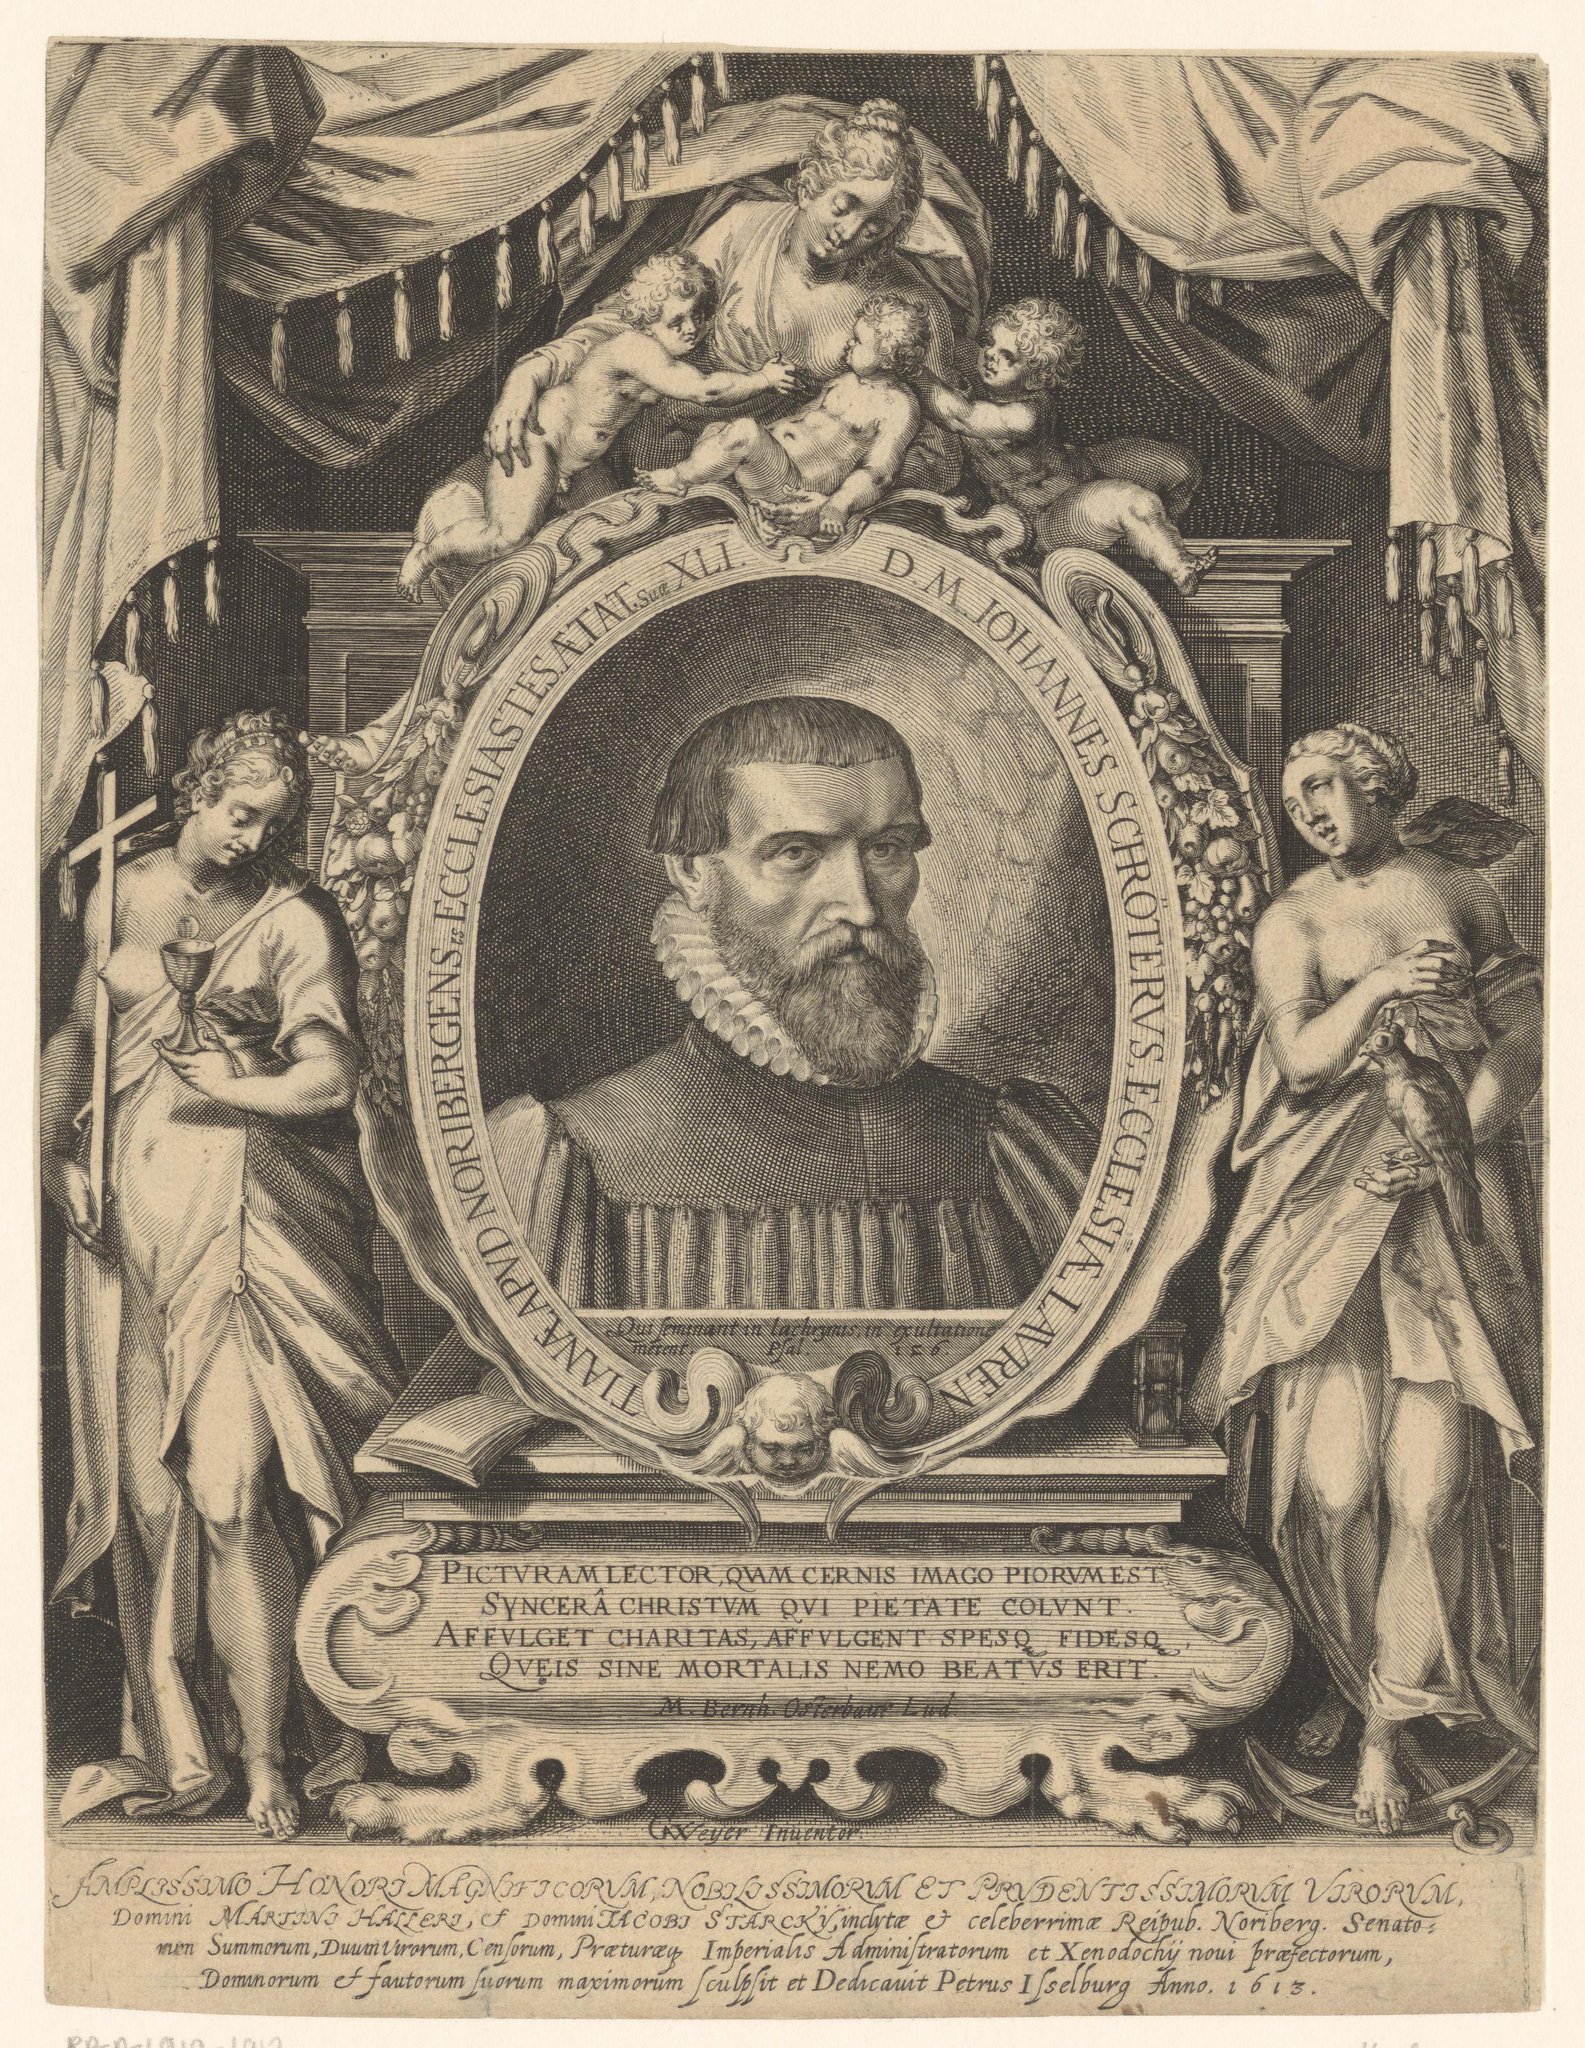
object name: print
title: Portret van Johann Schröder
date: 1613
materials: paper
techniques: engraving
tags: theologian, historical persons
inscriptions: collector's mark: Lugt 2228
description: Deze prent maakt mogelijk onderdeel uit van een serie met portretten van predikanten en theologen, naar ontwerp van Gabriel Weyer.